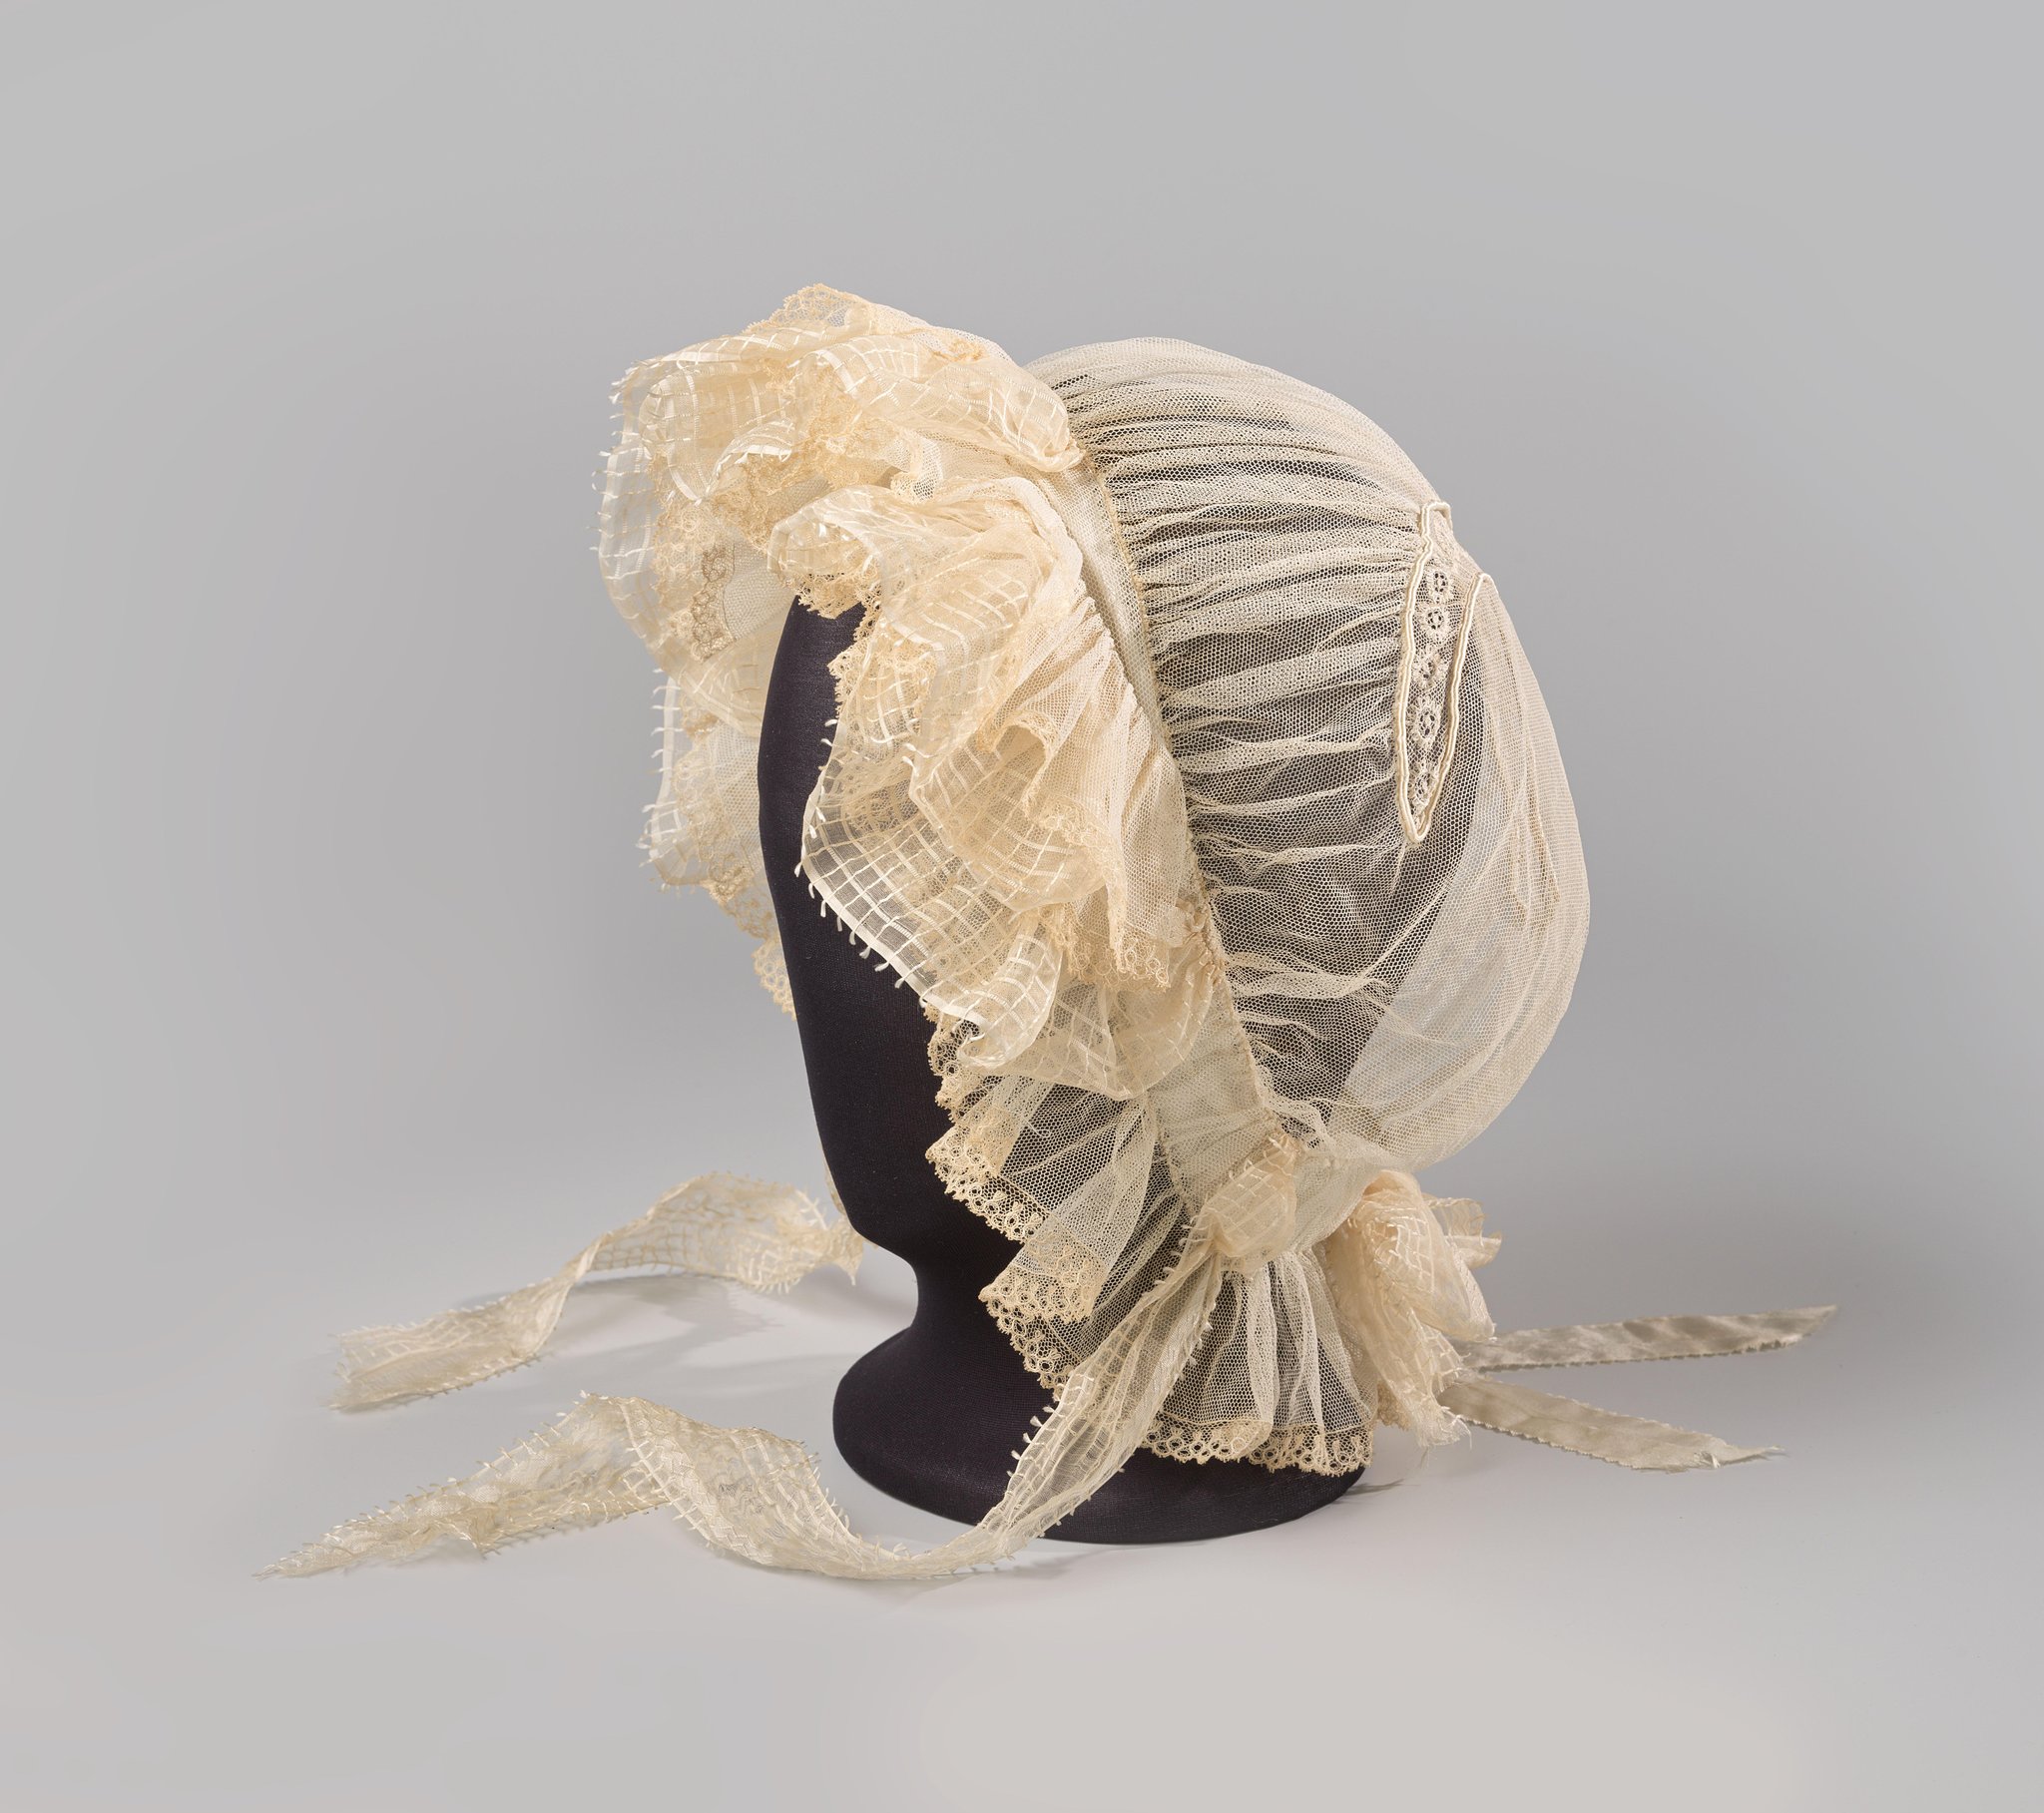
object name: cap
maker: Anonymous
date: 1810-1825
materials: silk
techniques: lace, weave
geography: france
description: Natural coloured sheer silk fabrics were in vogue in the early 19th century. A good example is this cap made of tulle and unbleached blonde bobbin lace. Most tulle, from very fine to very coarse, was machinemade in England, whereas the most exquisite bobbin laces came from Brussels and ‘Mechlin’ (Mechelen). These two fabrics were often combined, primarily in caps.